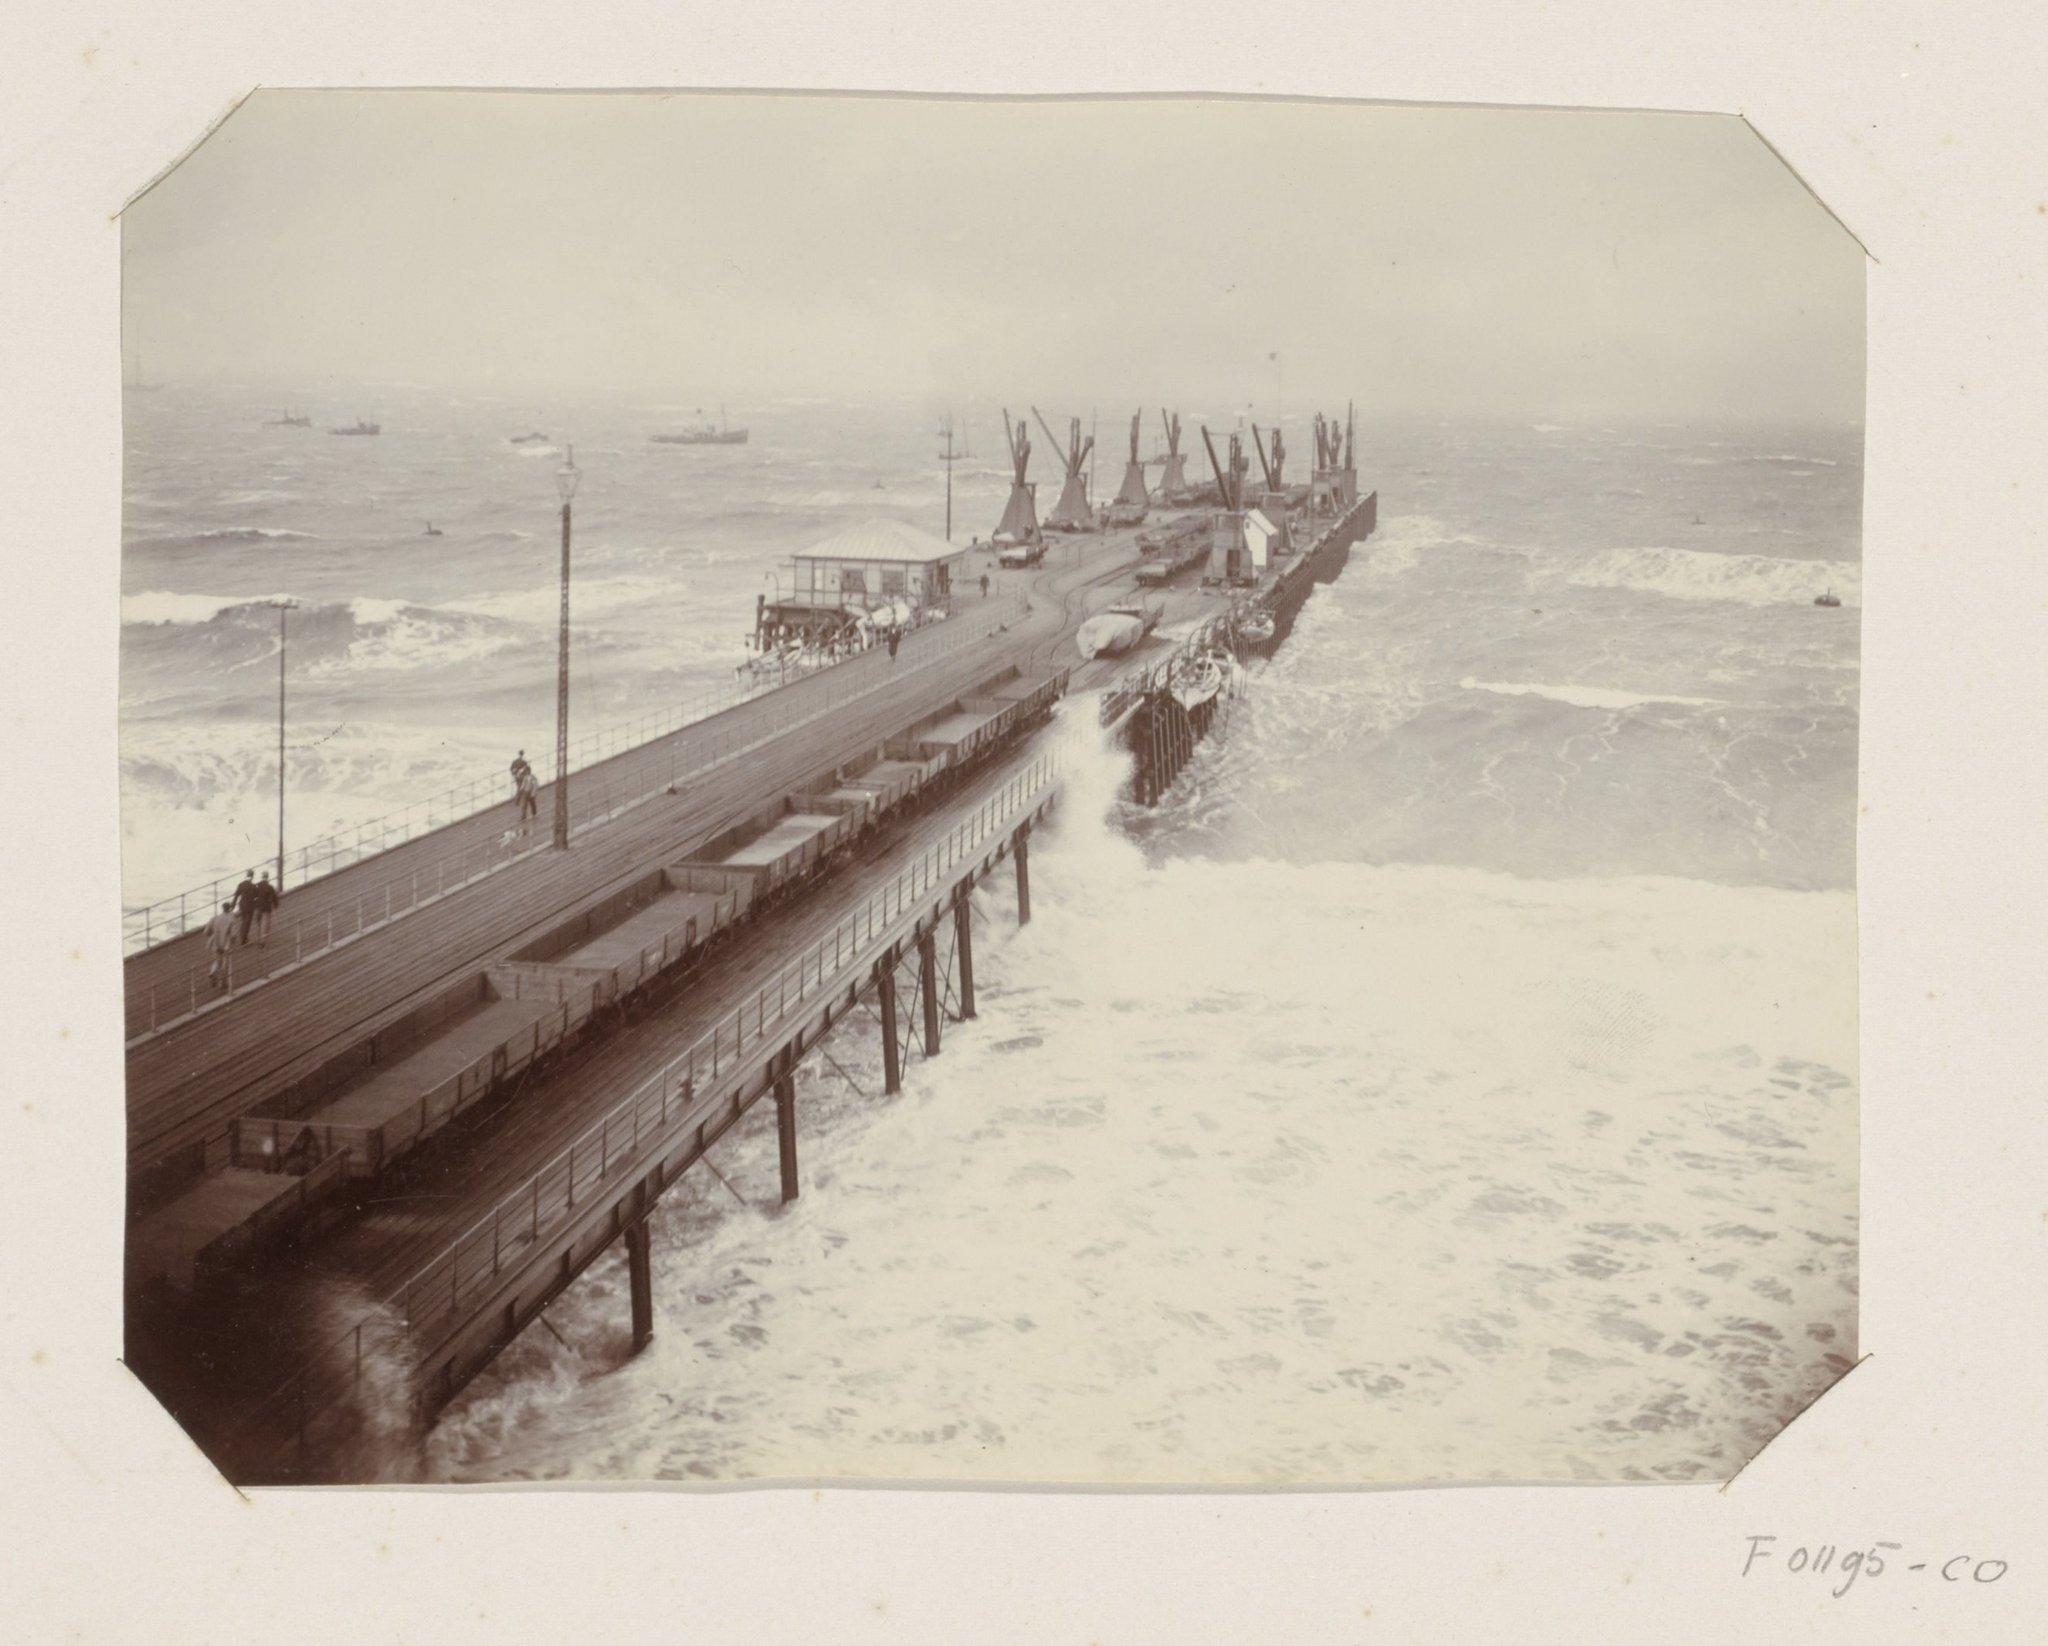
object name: photograph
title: Pier met spoorweg en hijskranen, vermoedelijk in Zuid-Afrika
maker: Anonymous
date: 1880-1910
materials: cardboard, paper, photographic support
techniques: gelatin silver print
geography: south africa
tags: pier, quay, wharf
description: Onderdeel van Fotoalbum van een reis door de Verenigde Staten, Honolulu, Nederlands-Indië, Aden, Zanzibar en Zuidelijk Afrika.